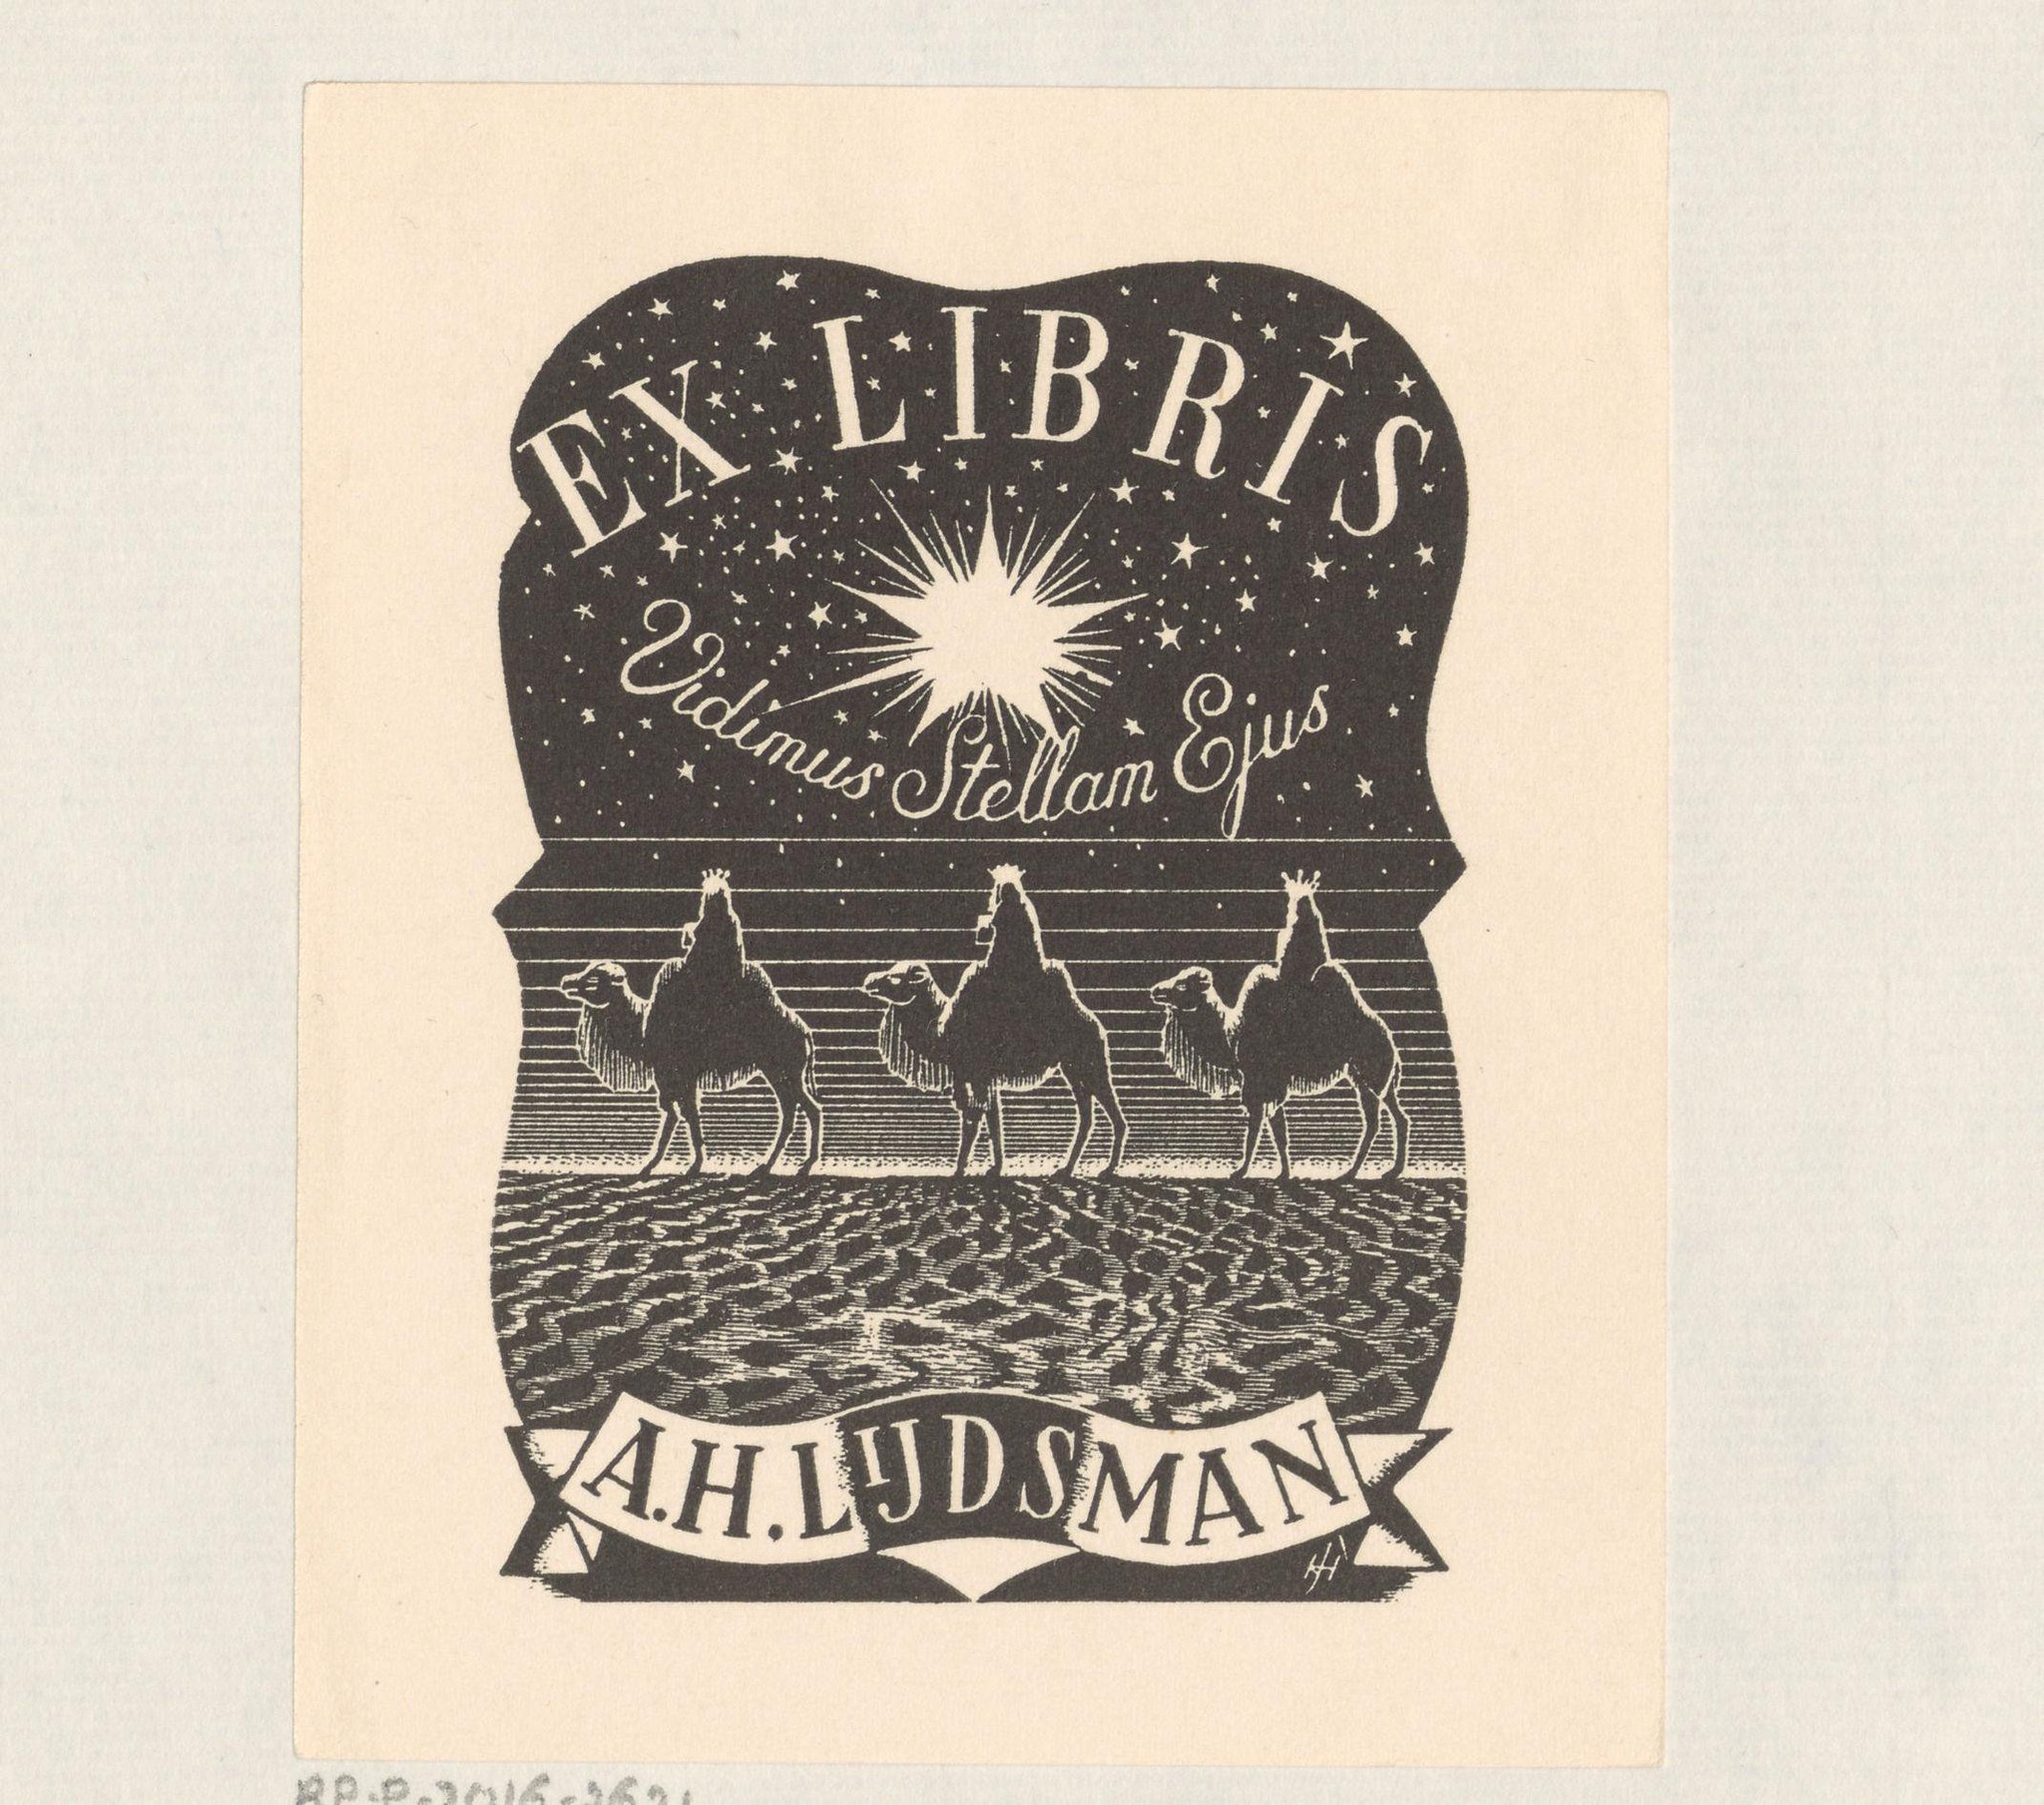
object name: bookplate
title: Vidimus stellam ejus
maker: Anonymous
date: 1900-1999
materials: paper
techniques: printing block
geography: netherlands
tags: the three kings, from israel, judah and edom, consult elisha, stars